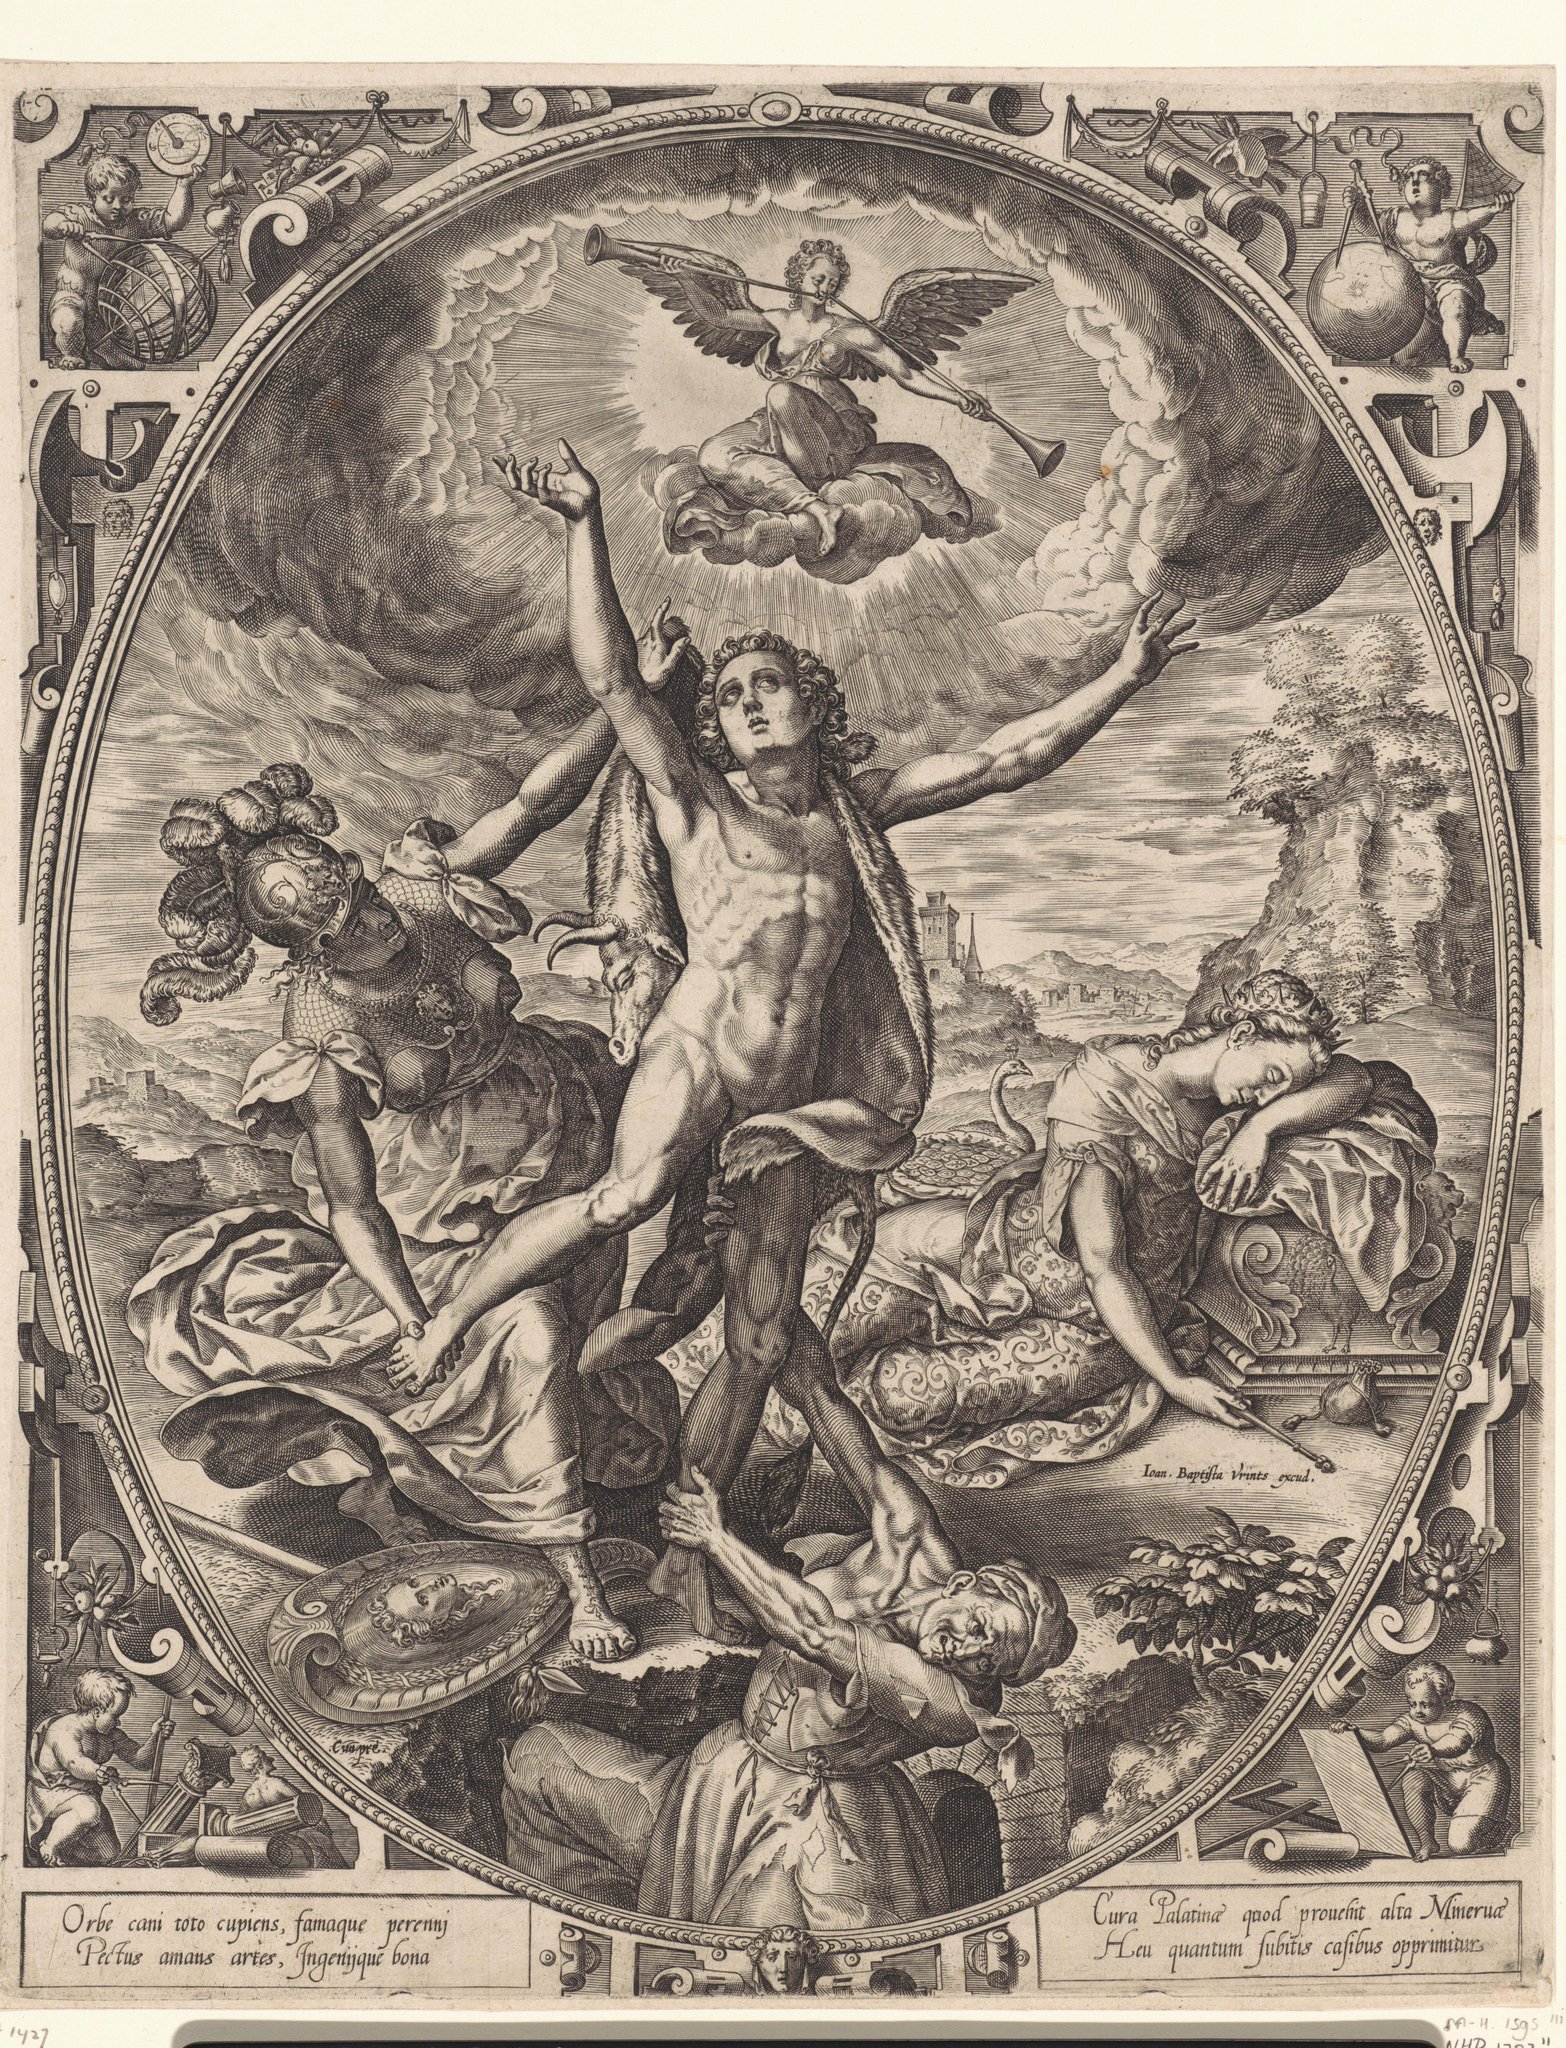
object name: print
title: Hercules op de tweesprong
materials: paper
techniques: engraving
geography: antwerp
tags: figure representing a virtue vs. a vice, (story of) juno (hera), 'astronomia', 'cosmografia'; 'cosmografia' (ripa), arithmetic, descriptive geometry, specific aspects, allegorical aspects of minerva; minerva as patroness (+ variant), hercules at the cross-roads, 'herkules am scheidewege': the choice of hercules (+ variant), 'architectura', symbolic representations, allegories and emblems ~ architecture; 'architettura' (ripa), fame; 'fama', 'fama buona', 'fama chiara' (ripa)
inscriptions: collector's mark: Lugt 240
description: Hercules wordt door de personificatie van Ondeugd mee de afgrond ingetrokken terwijl Minerva als de personificatie van de Deugd hem probeert terug te trekken. Ze wijst op de Faam die aan de hemel op haar bazuin blaast. Rechts slaapt Juno. De voorstelling is gevat in een ovale omlijsting. De hoeken zijn gedecoreerd met putti met symbolen van de kunsten en wetenschappen: astronomie (linksboven), geometrie (rechtsboven), architectuur (linksonder) en aritmetrie (rechtsonder).